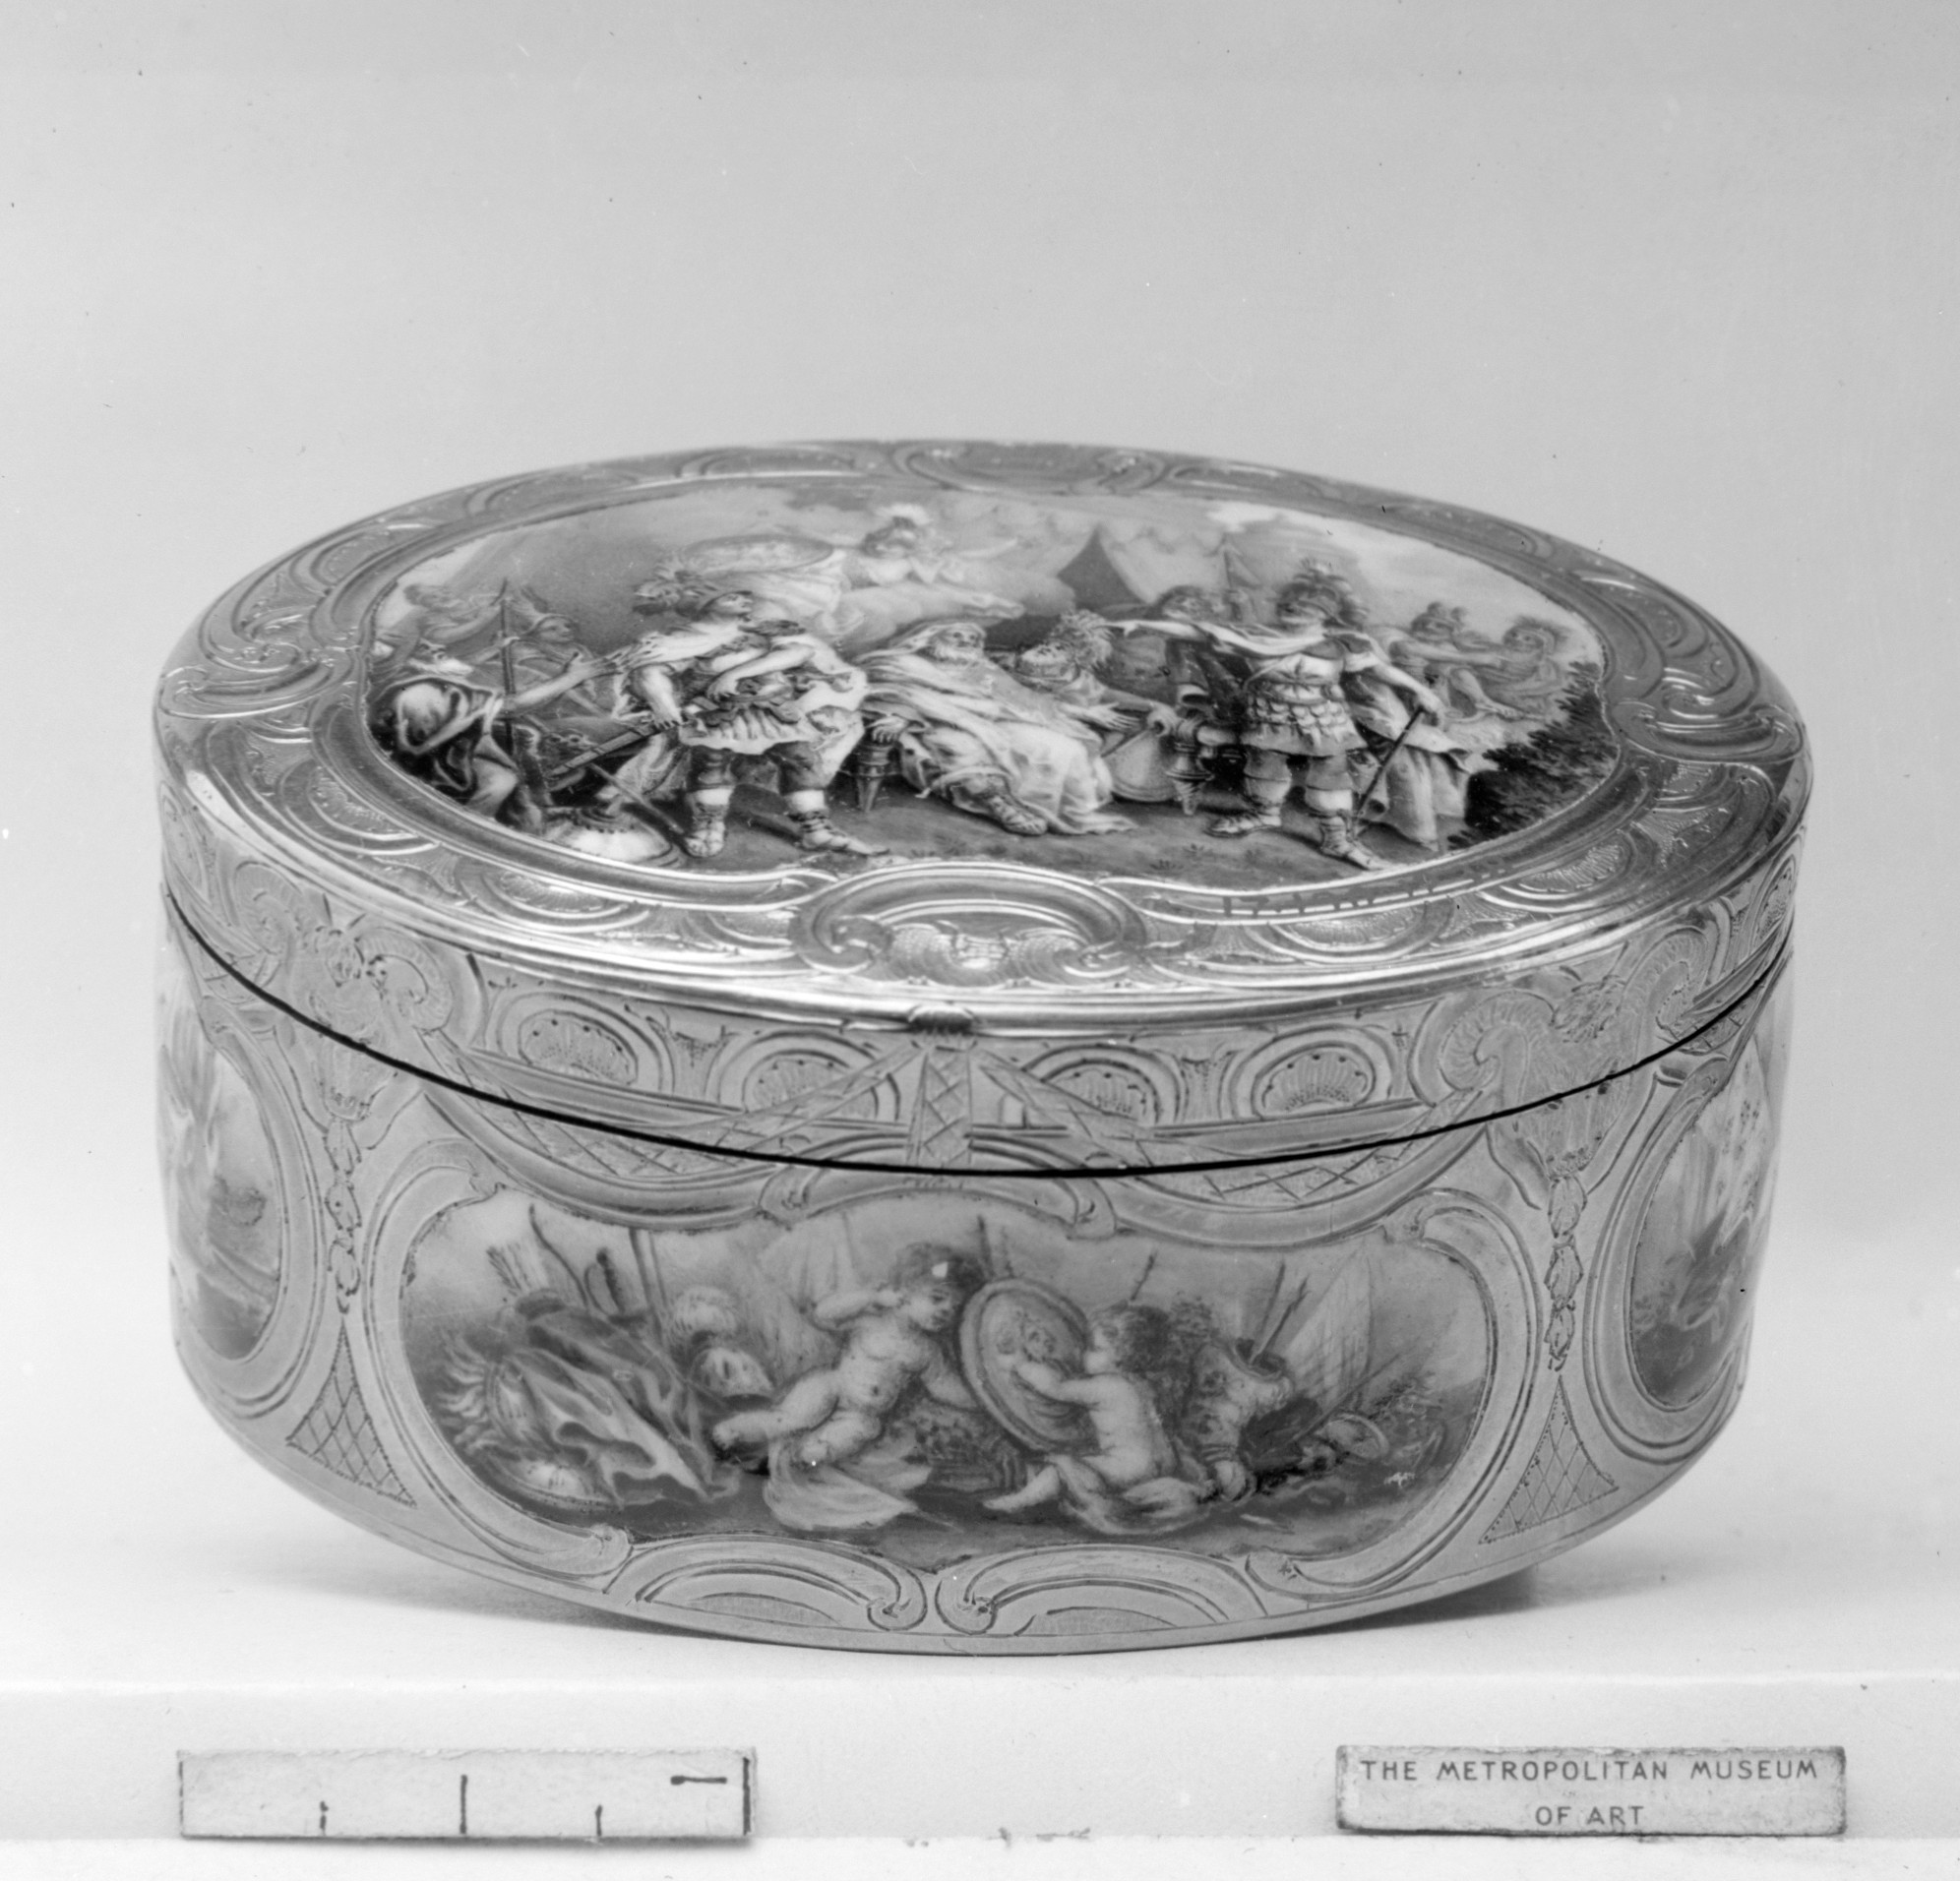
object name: snuffbox, painting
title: Snuffbox with scenes from the life of Achilles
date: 1701-1800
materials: enamel, gold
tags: men,achilles,putti